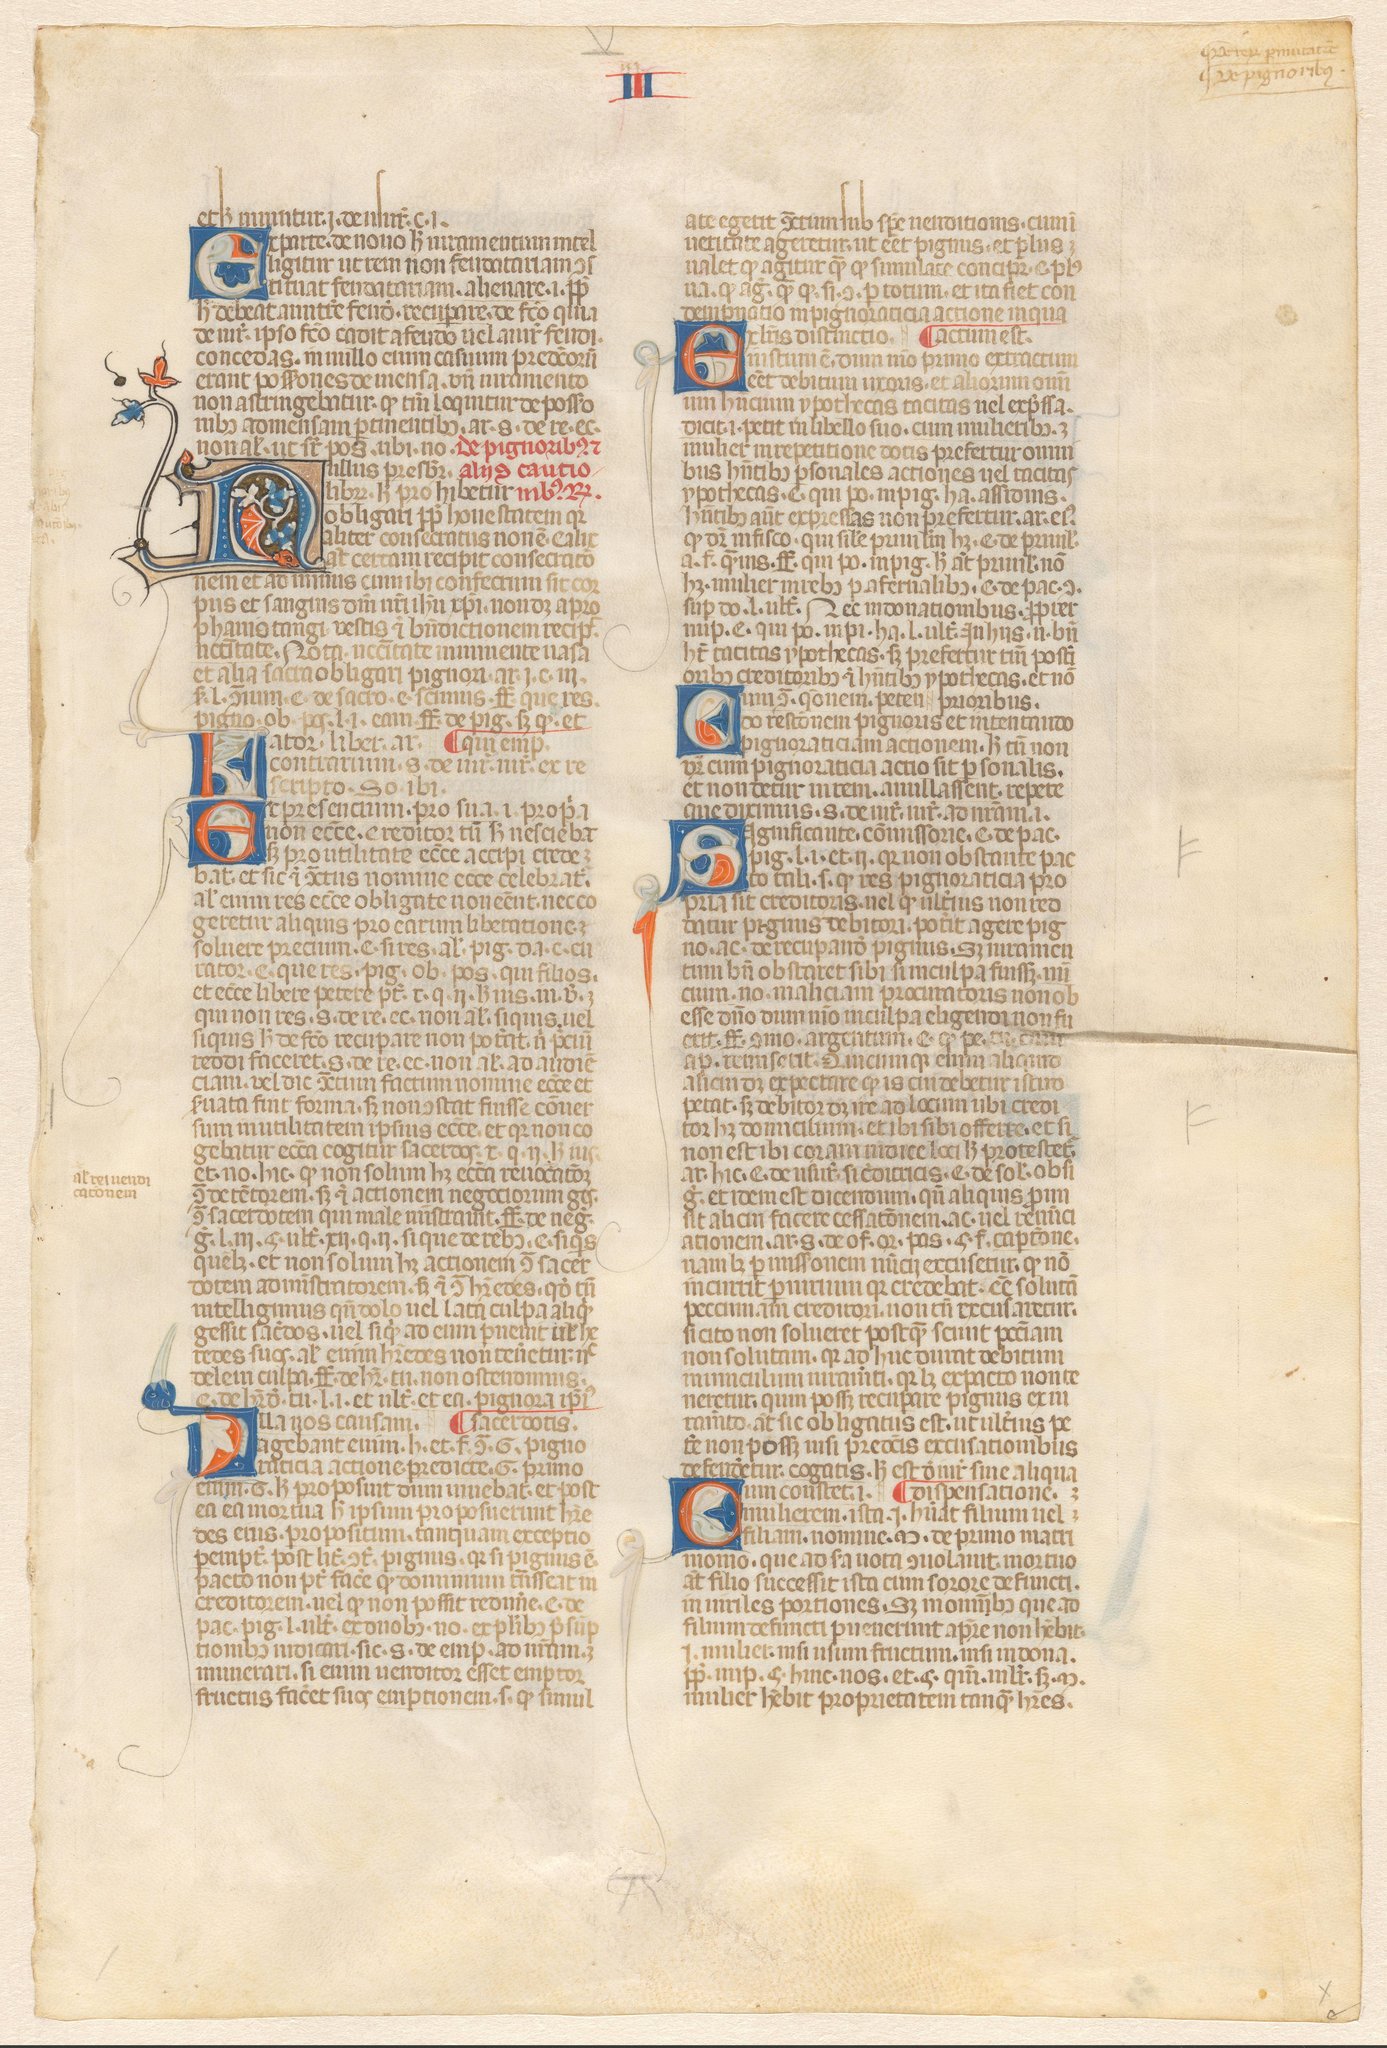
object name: page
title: Blad uit Gregorius IX, Decretales, lib. III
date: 1300-1399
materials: paint, gold leaf, ink, parchment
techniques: brush, pen